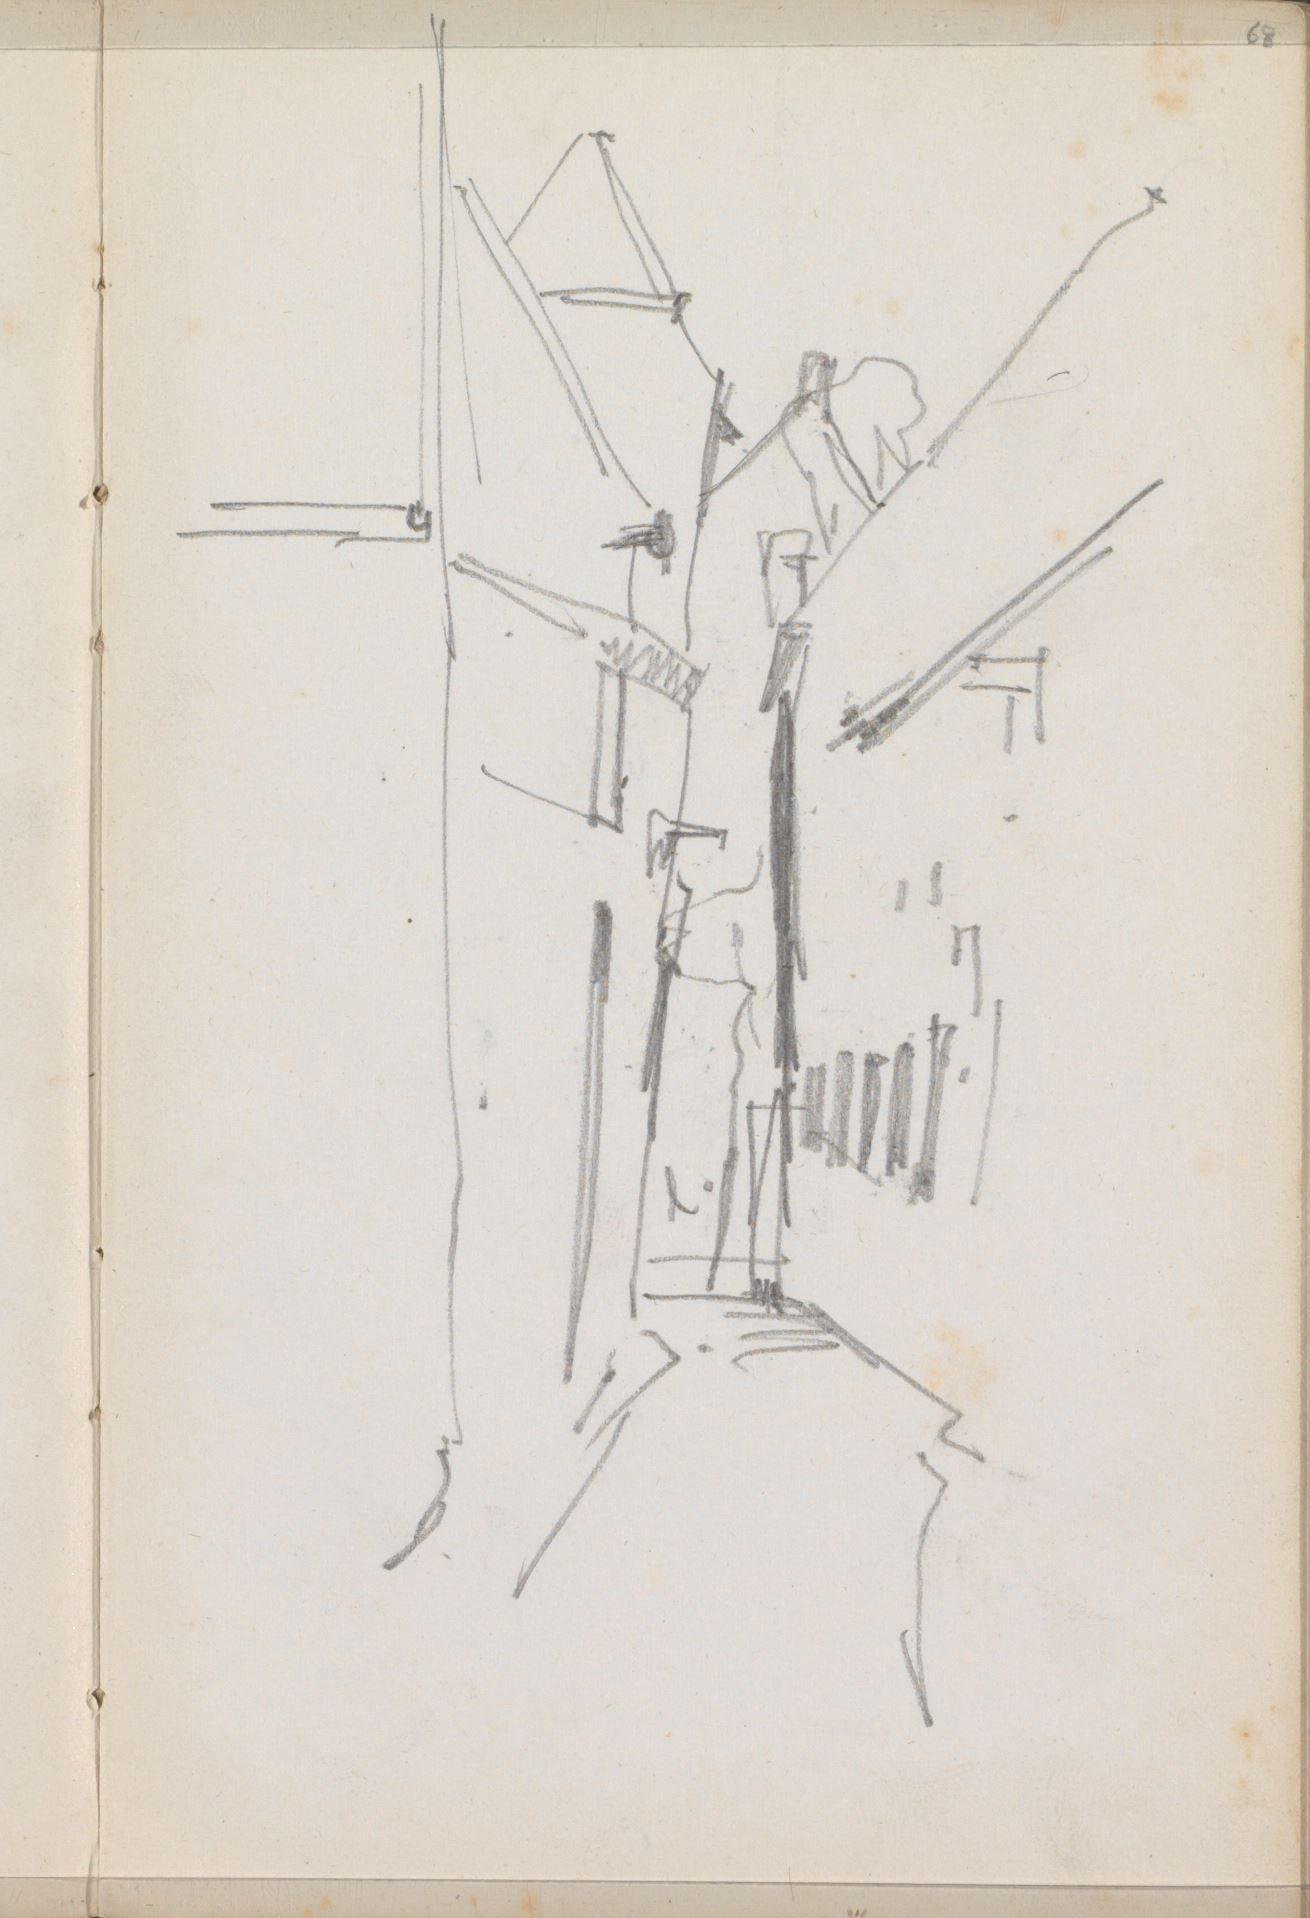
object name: sketchbook leaf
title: Gezicht op een steeg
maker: george hendrik breitner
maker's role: draughtsman, painter, print maker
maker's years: 1857-1923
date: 1880-1882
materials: paper, pencil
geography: south holland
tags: lane, alley, civic architecture; edifices; dwellings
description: Pagina 68 uit een schetsboek met 72 bladen.